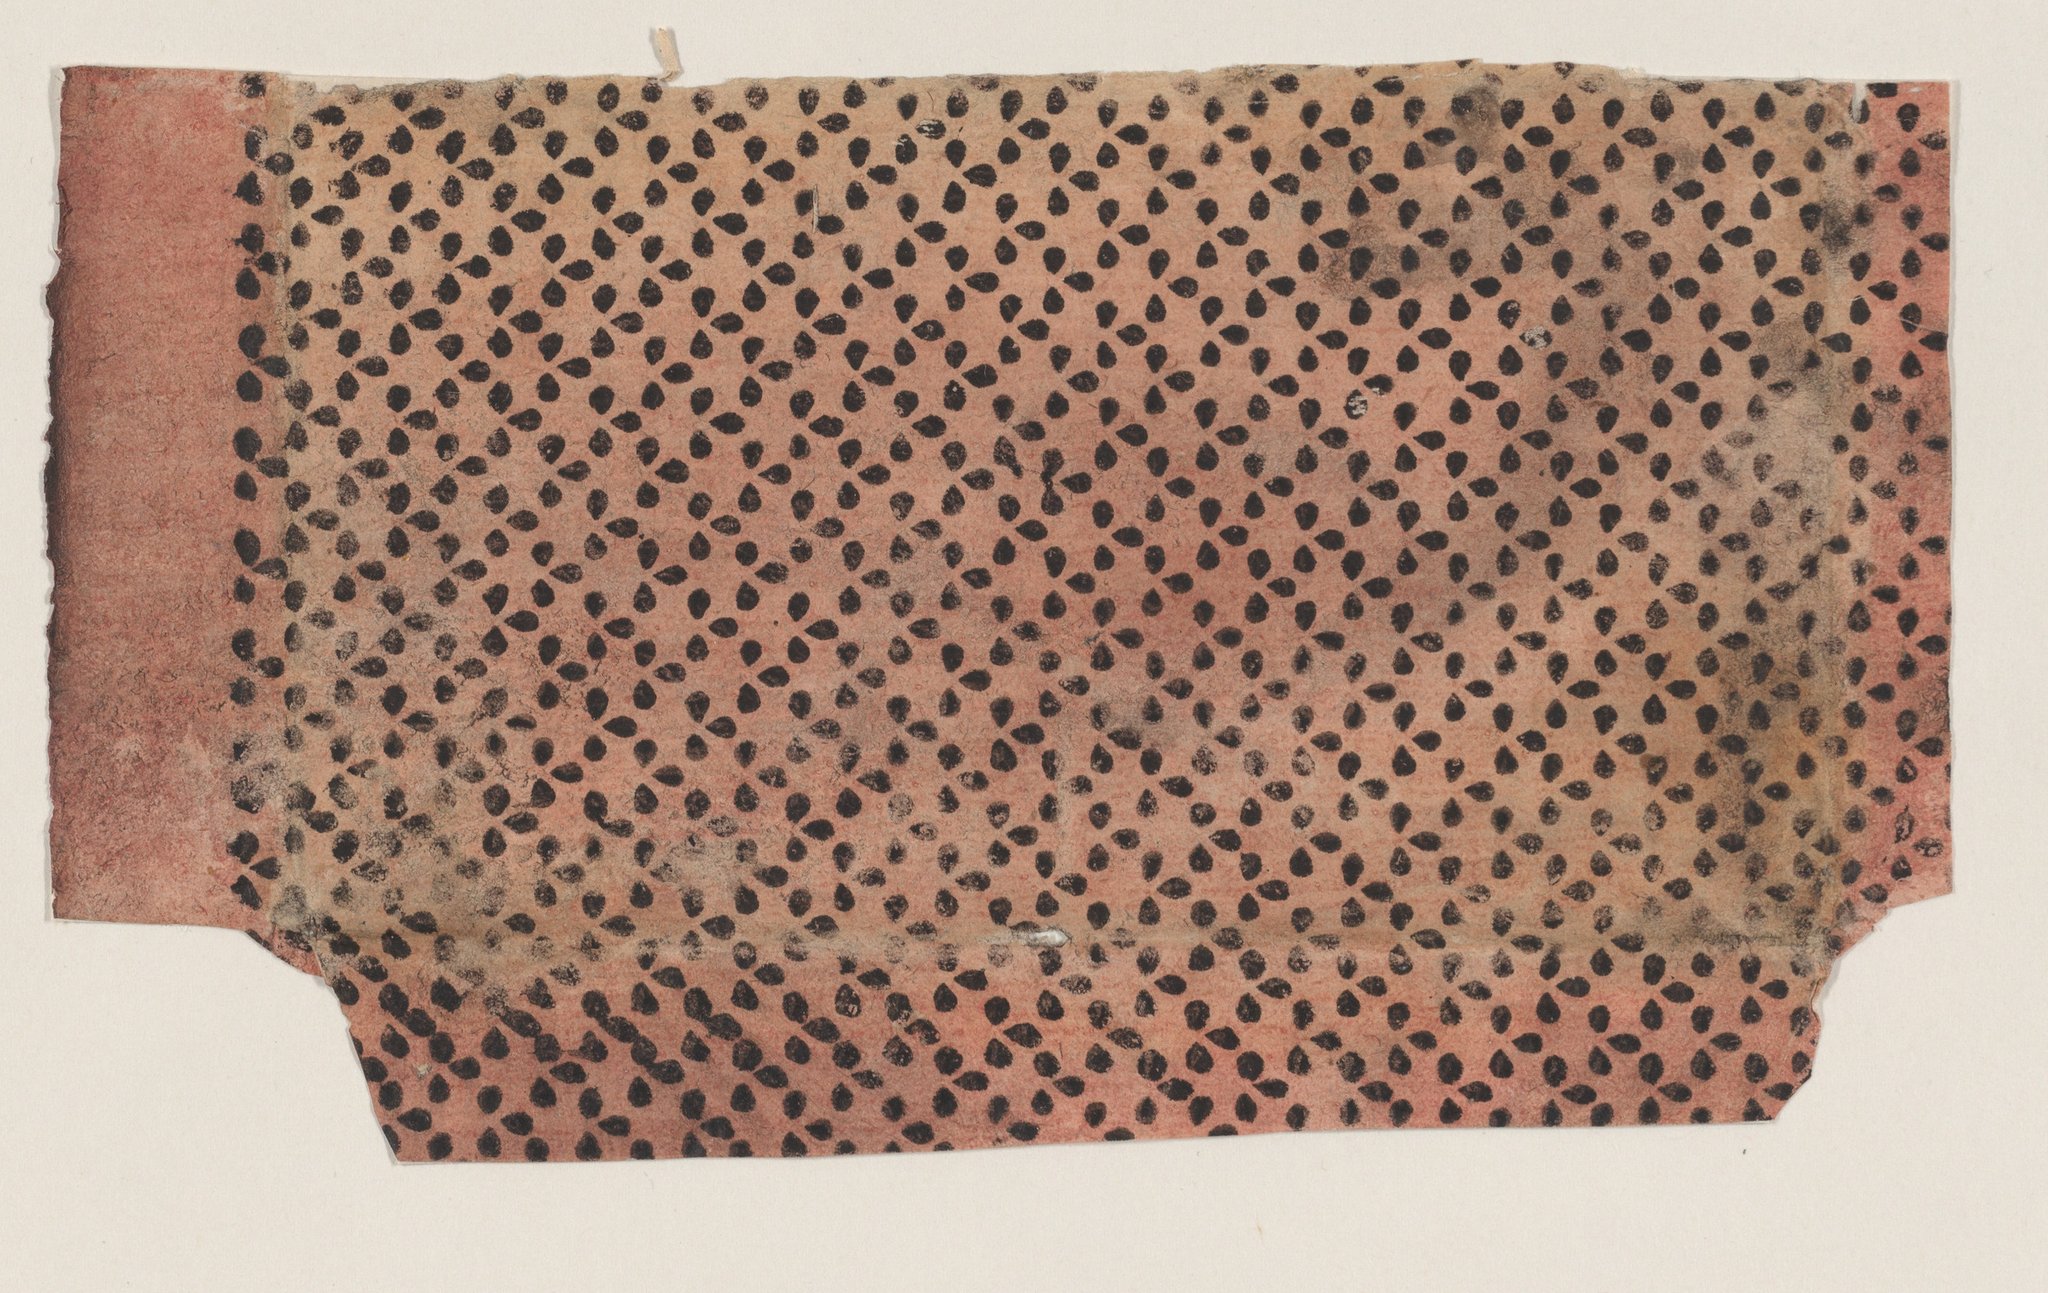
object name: print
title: Sheet with overall geometric pattern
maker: Anonymous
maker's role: artist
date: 1801-1900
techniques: relief print